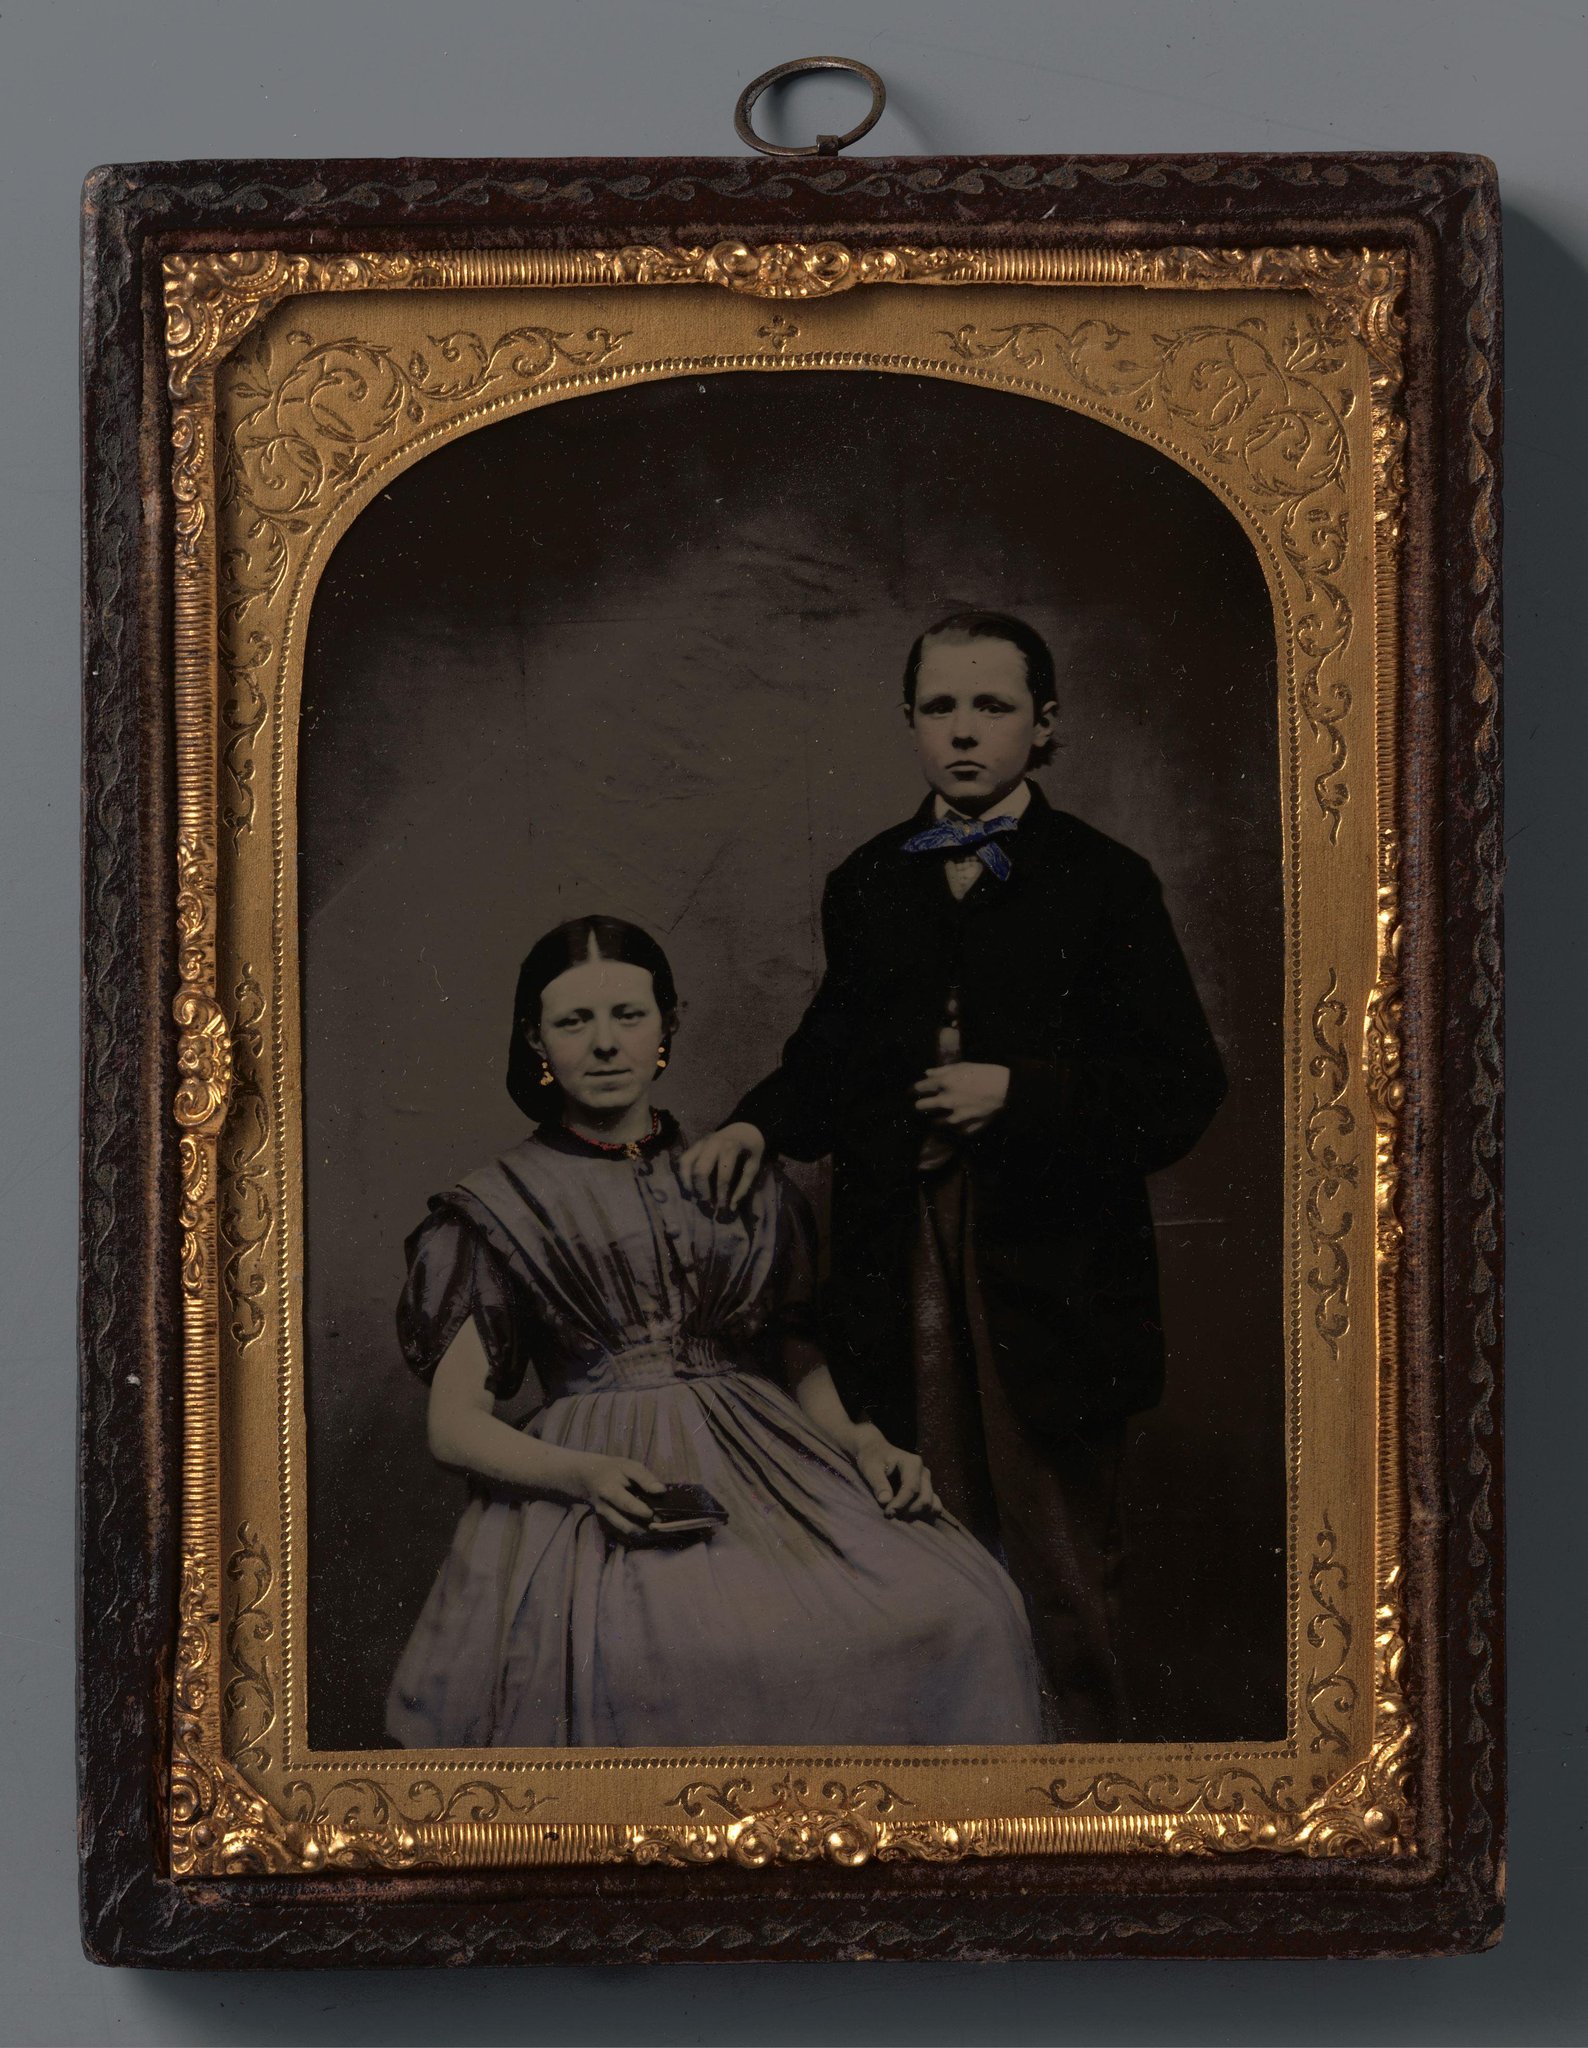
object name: photograph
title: Portret van een onbekend zittend meisje en een onbekende staande jongen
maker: james gregson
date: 1855-1870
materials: glass, metal, velvet, wood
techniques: ambrotype, hand coloring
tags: standing figure, sitting figure - aa - female human figure, boy (child between toddler and youth), historical persons, girl (child between toddler and youth)